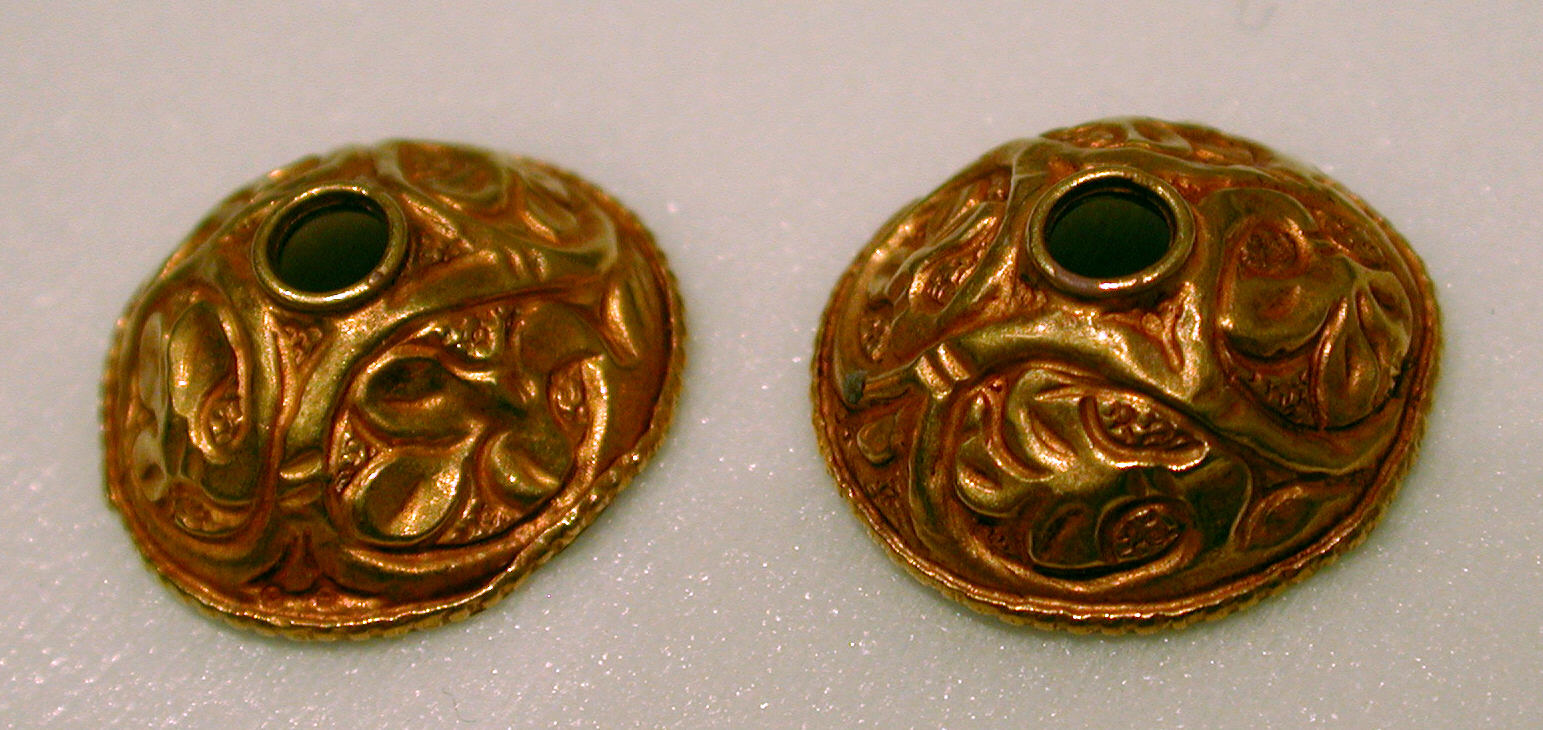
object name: element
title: Elements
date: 1001-1200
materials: gold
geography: iran